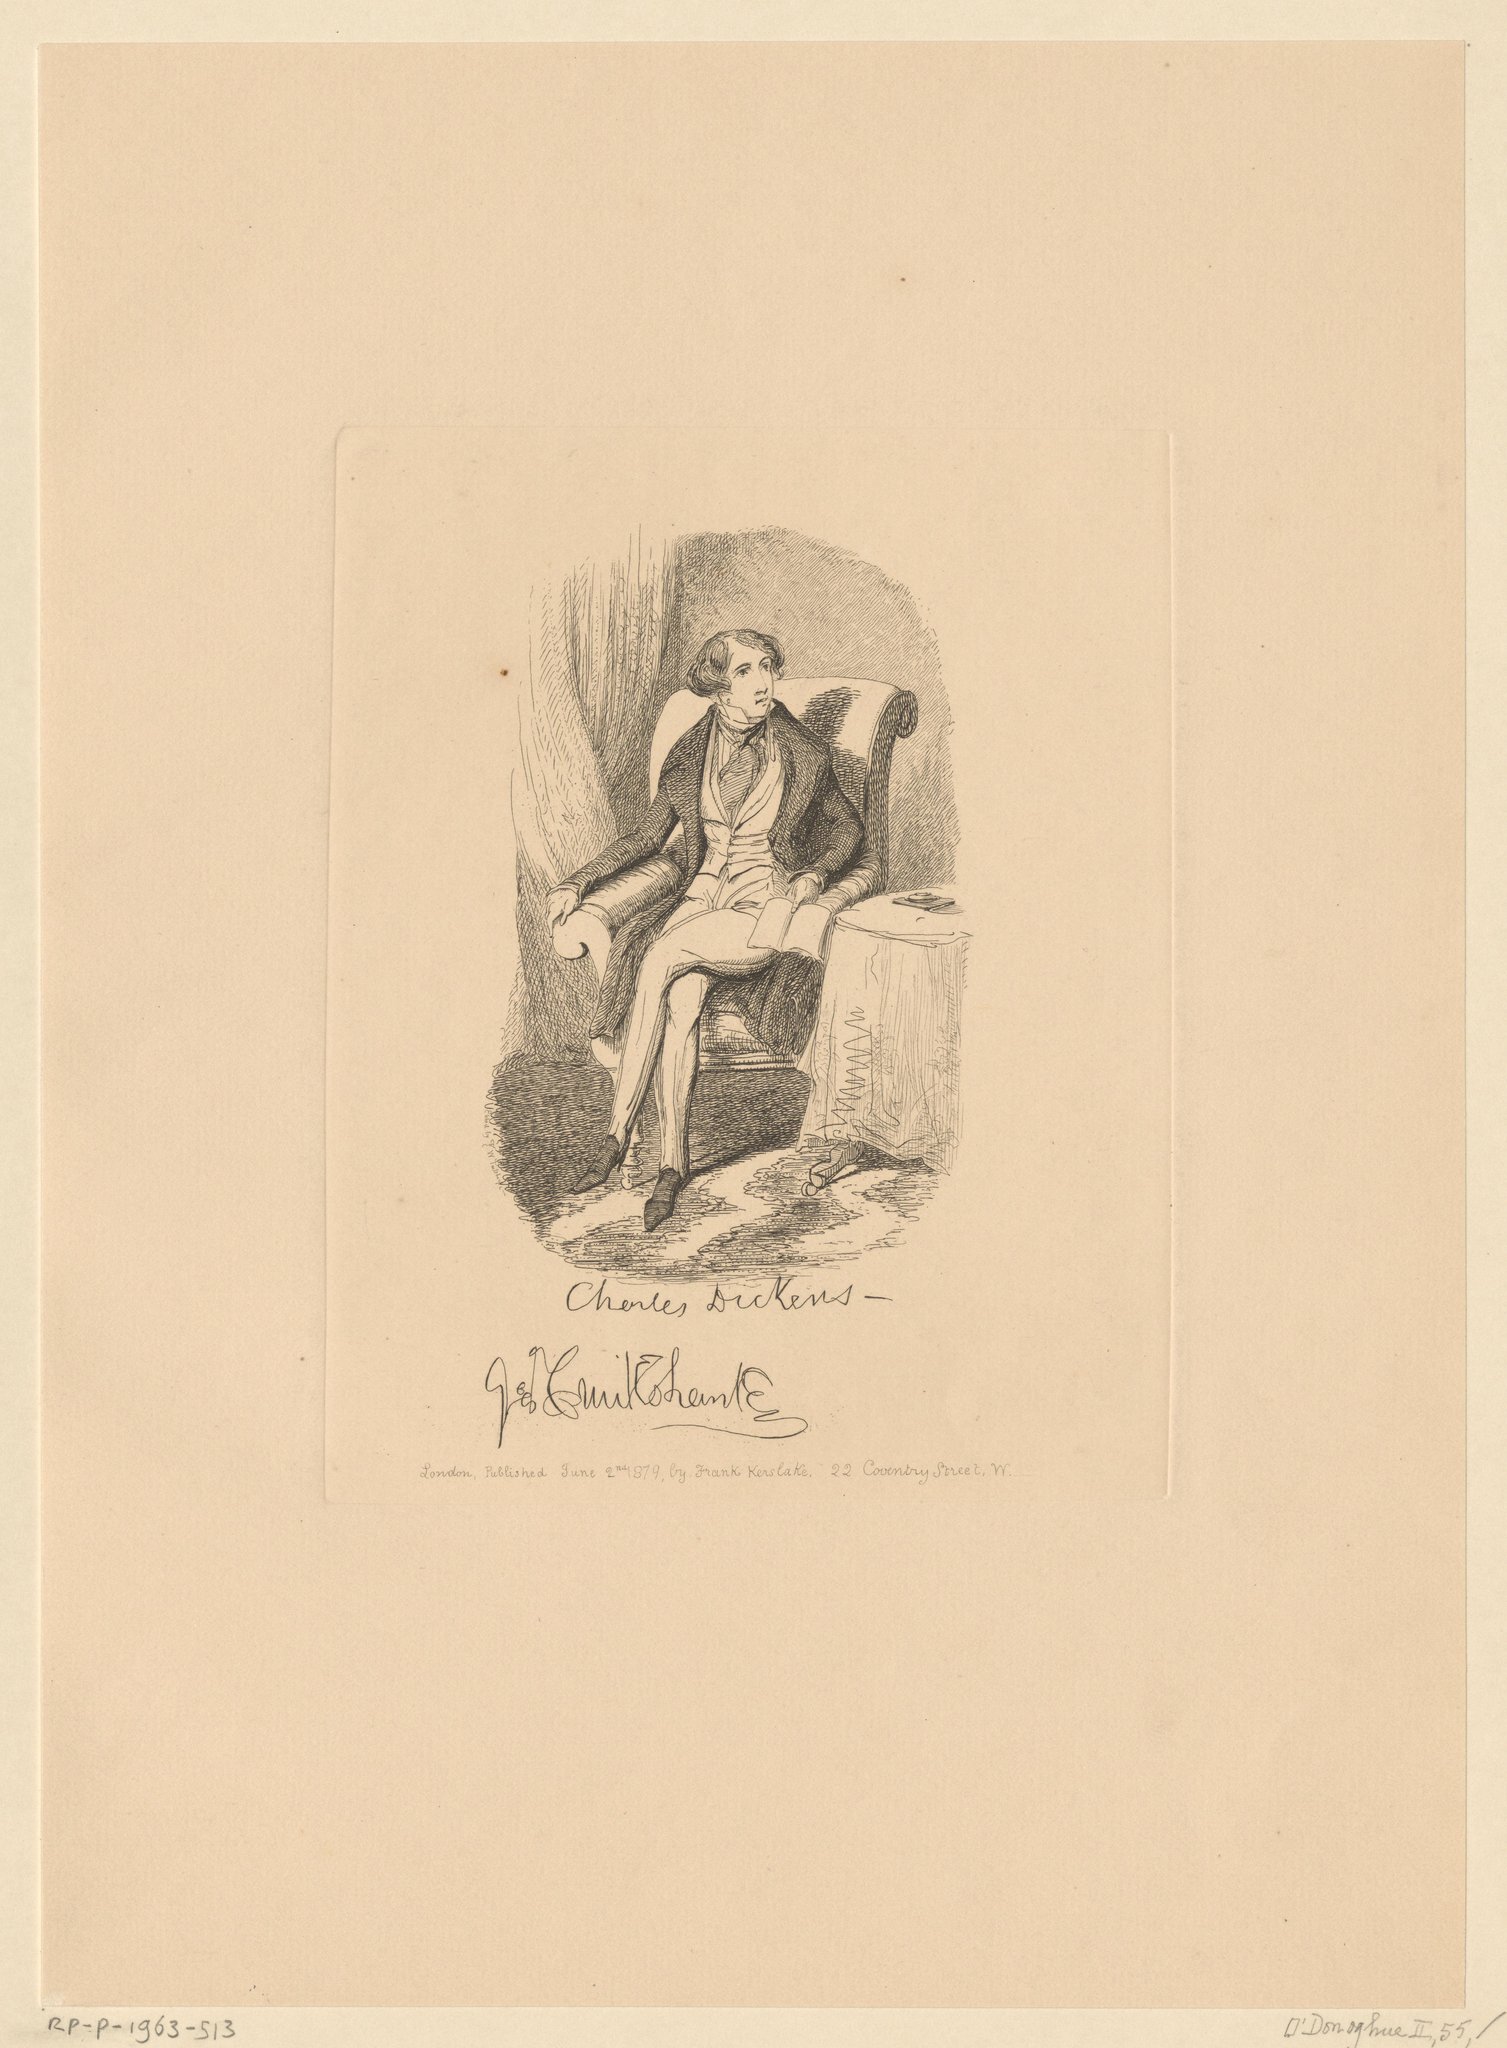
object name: print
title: Portret van Charles Dickens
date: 1879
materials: paper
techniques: etching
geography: london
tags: portsmouth, historical persons, portrait of a writer, book - mm - book open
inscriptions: collector's mark: Lugt 2228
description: Zittend op een stoel naast een tafel met een open boek in zijn linkerhand.